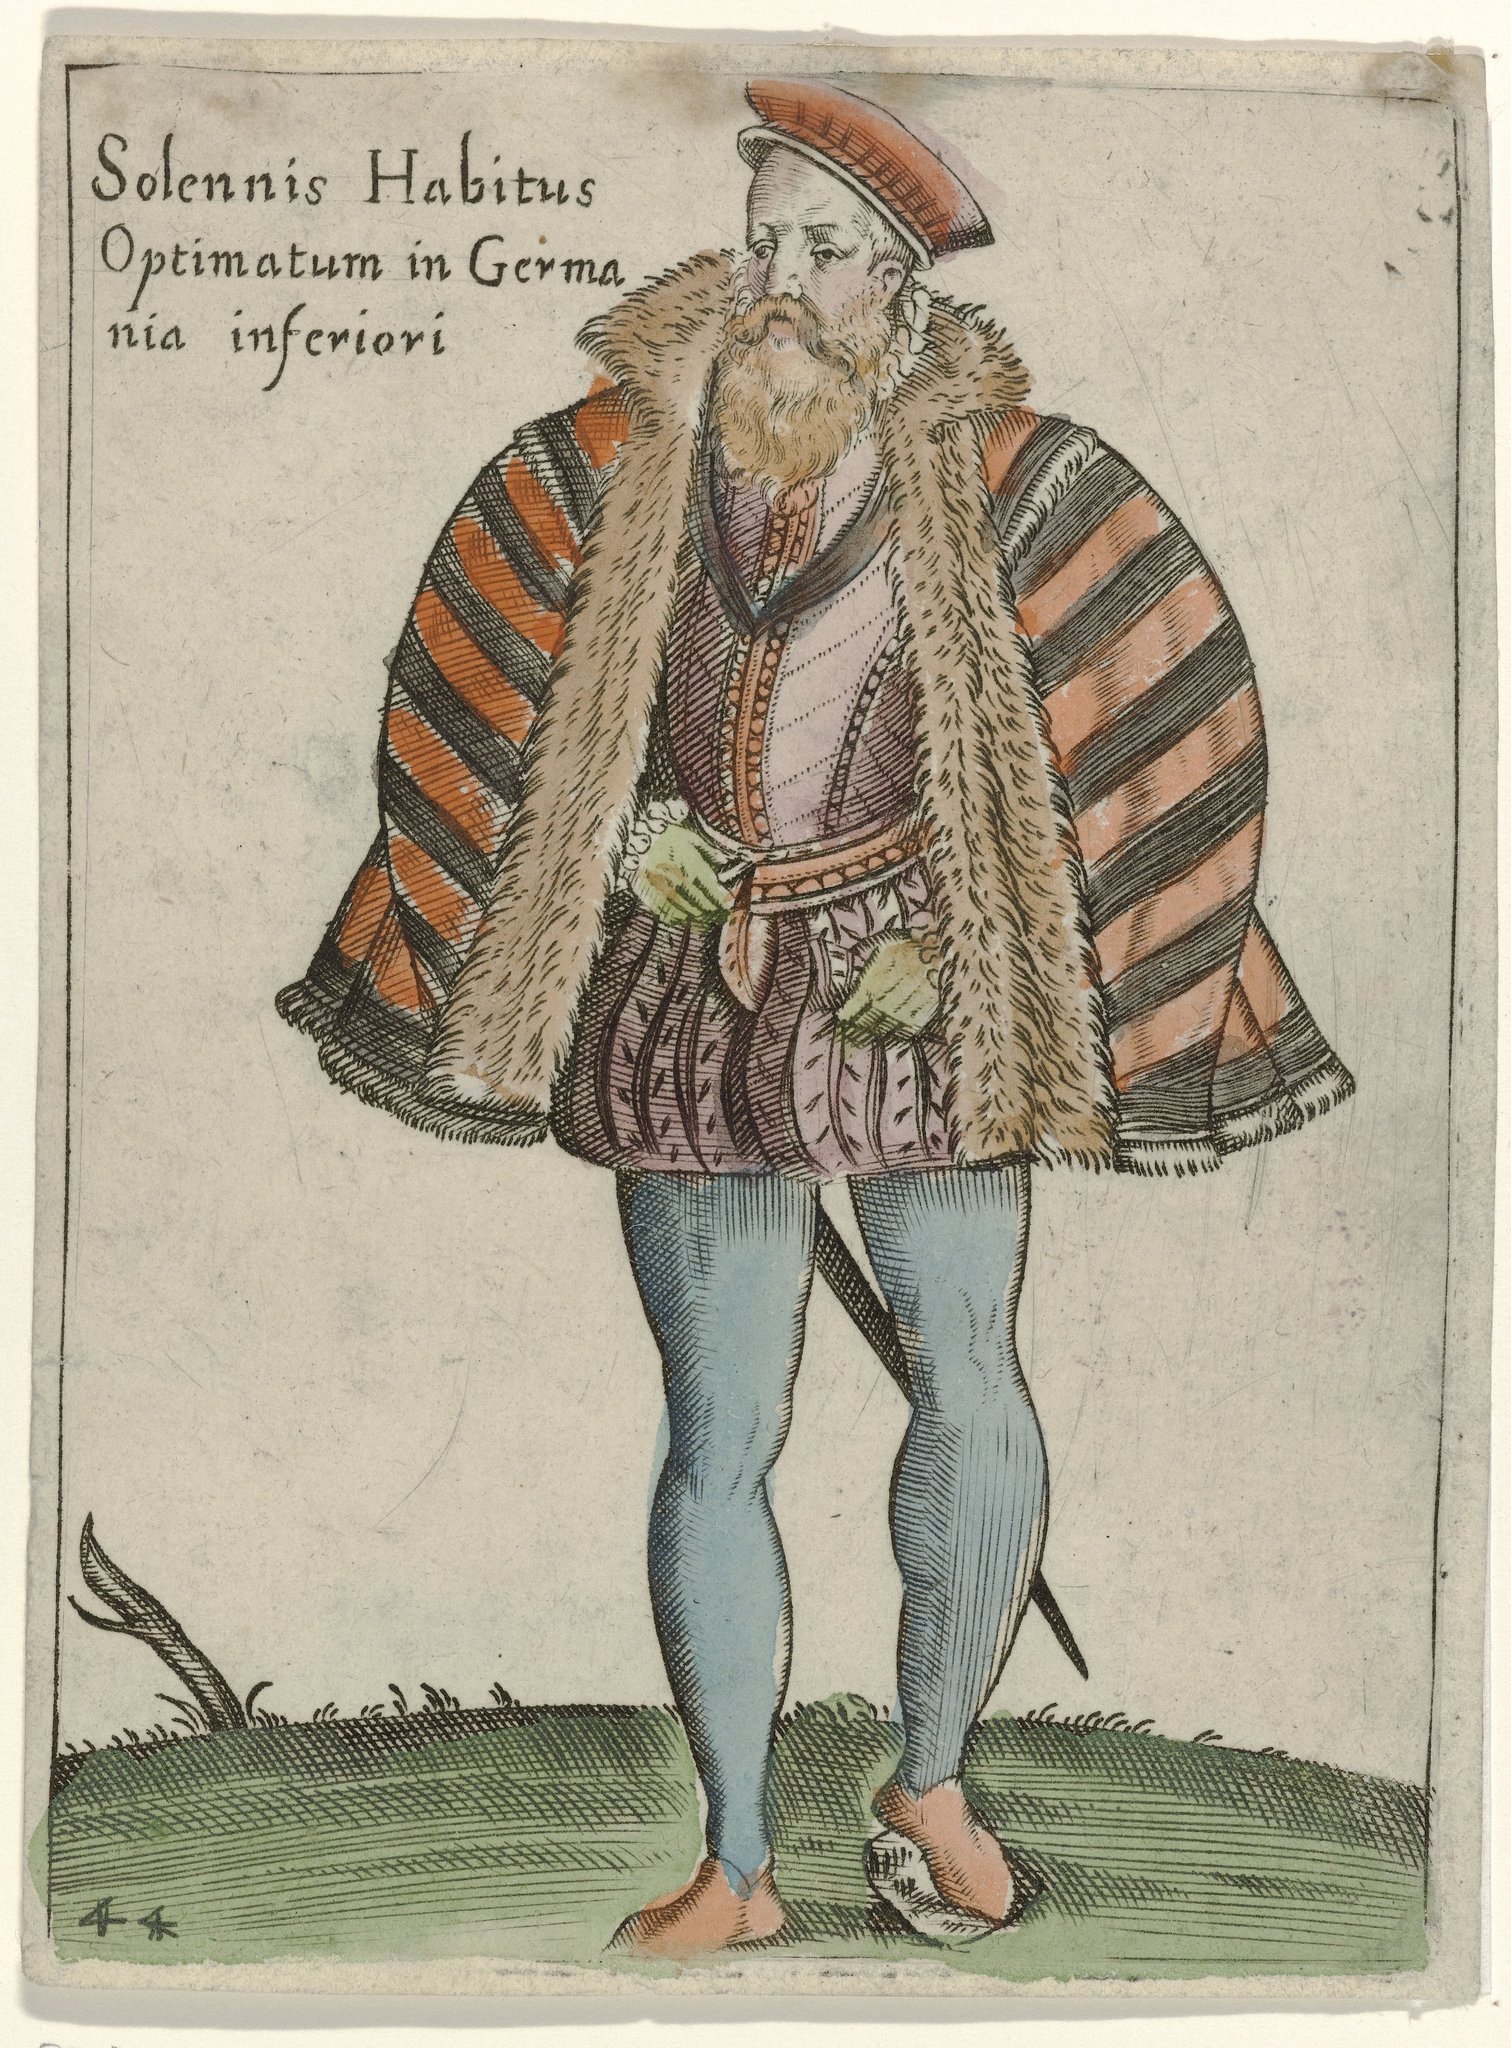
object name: costume print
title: Equituis germani domesticus Vestitus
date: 1592-1594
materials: paper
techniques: engraving, hand coloring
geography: padua